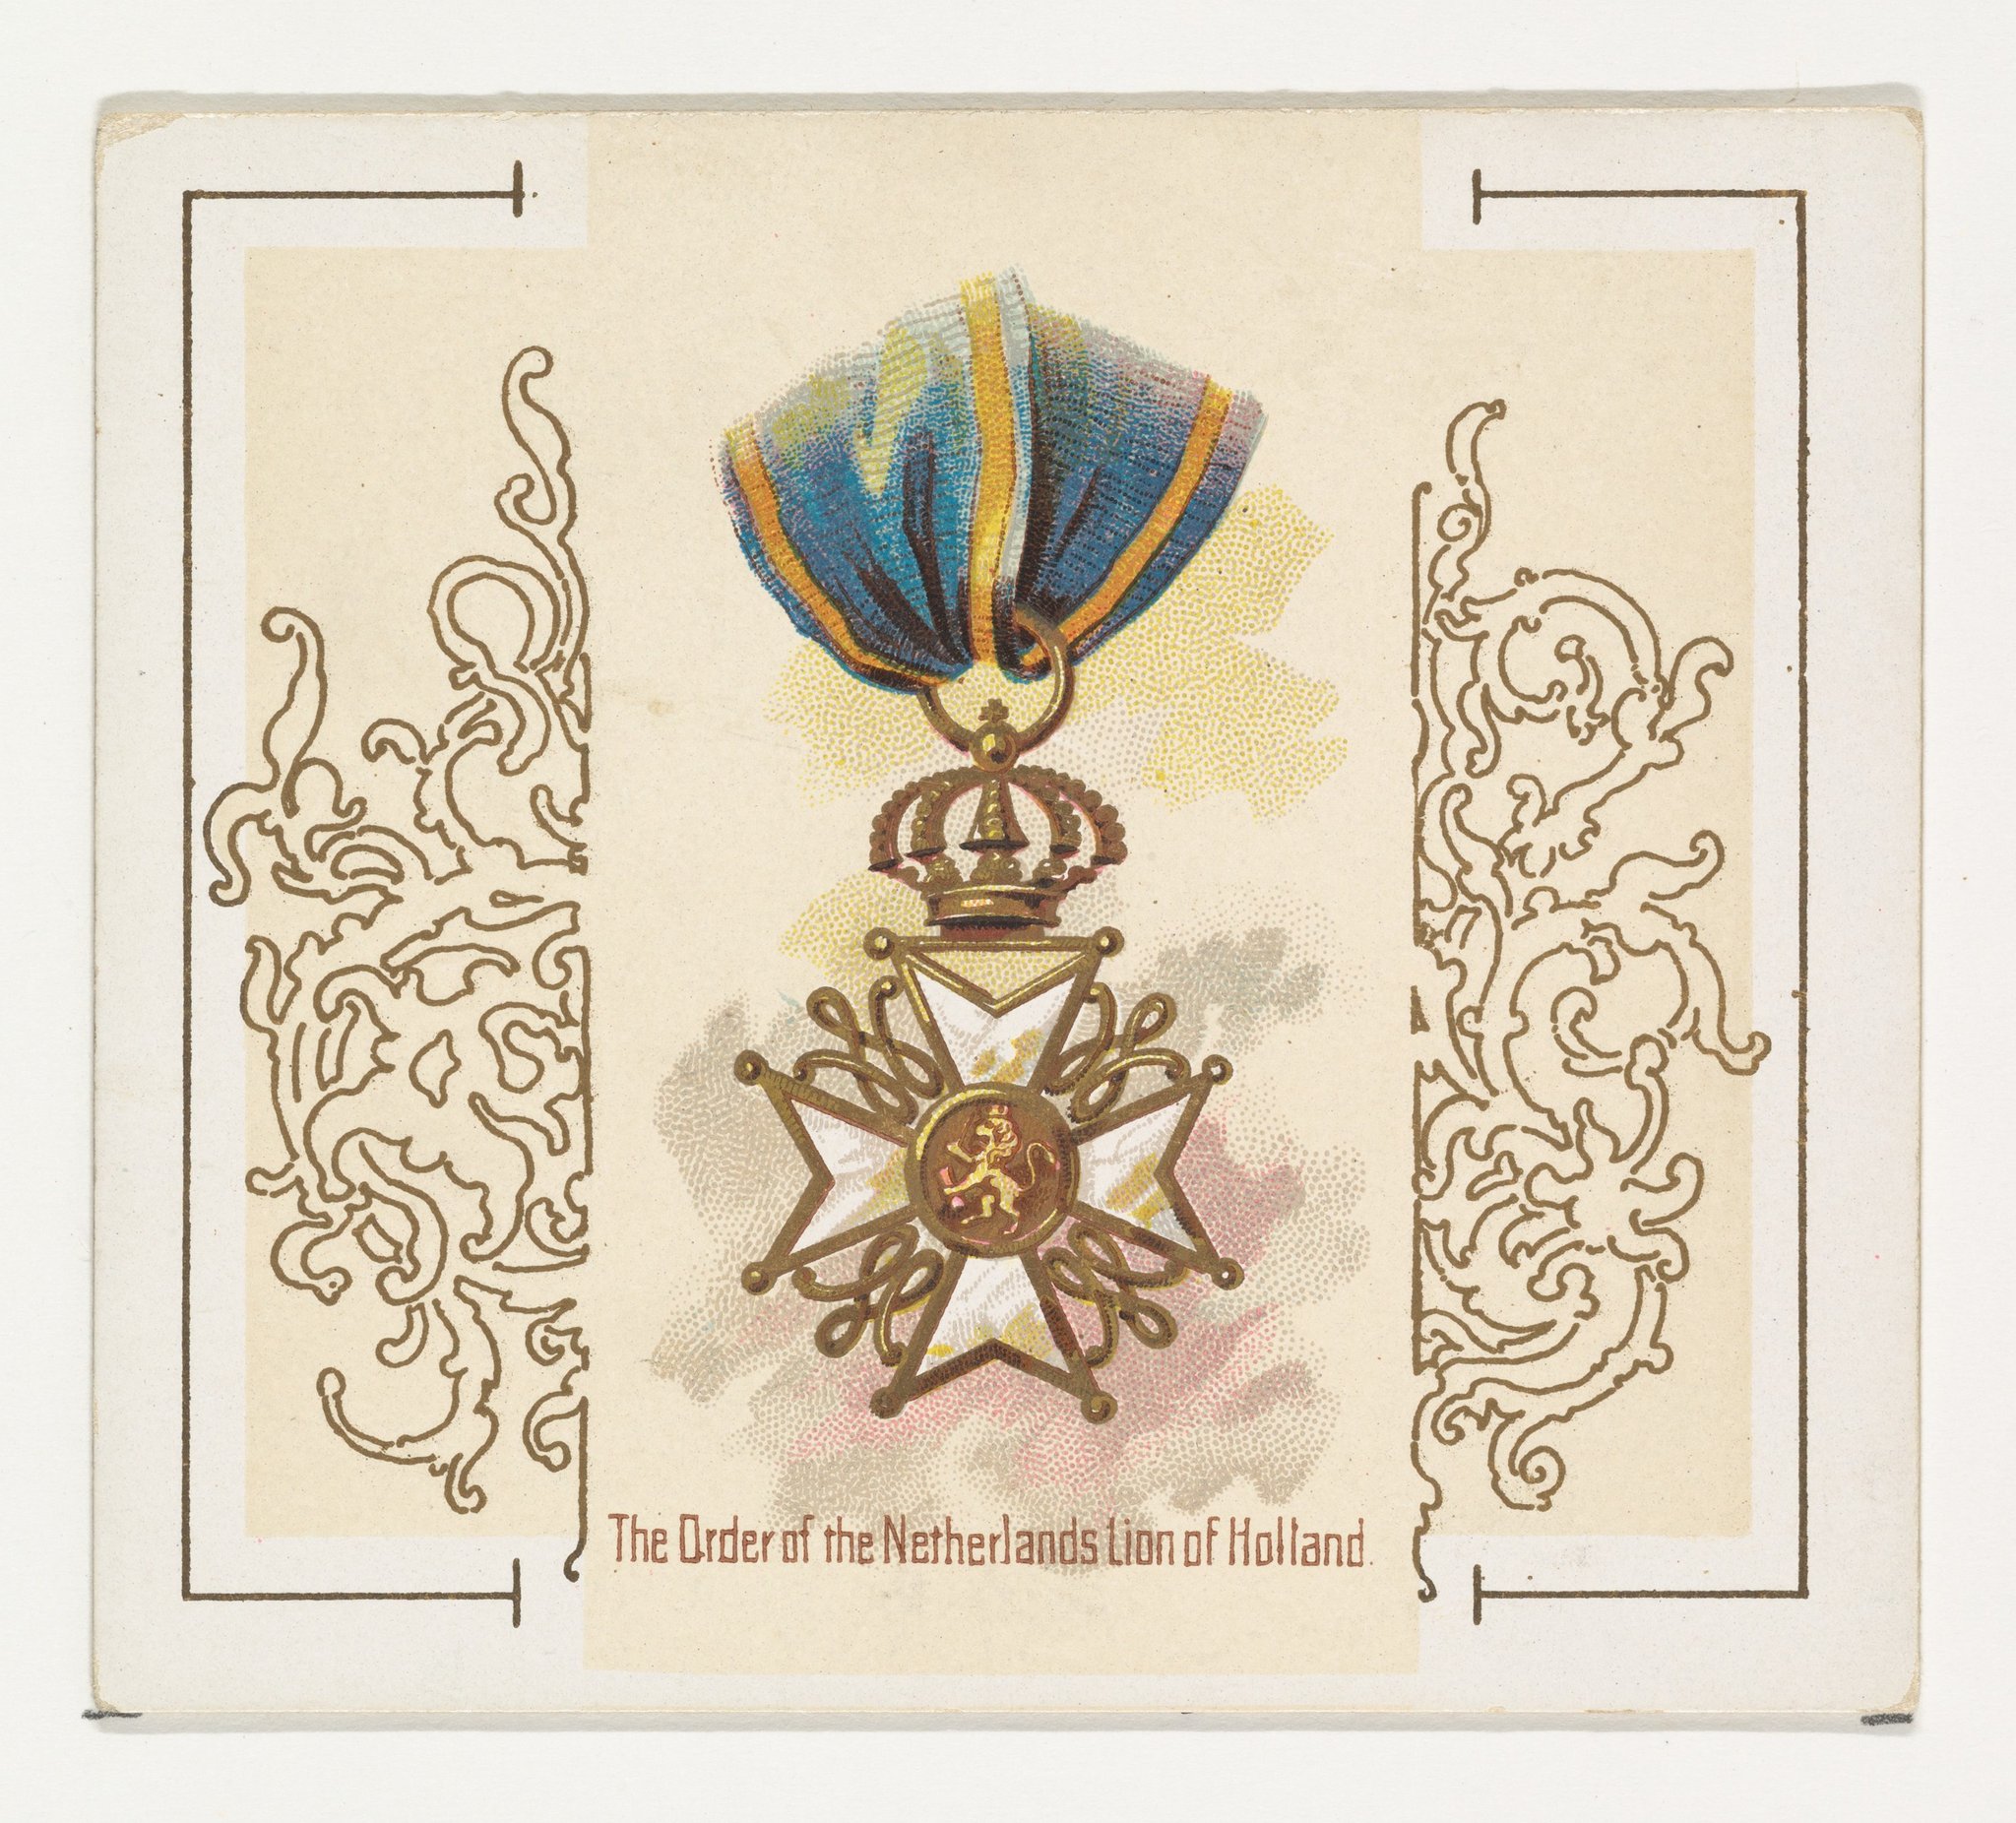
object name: print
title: The Order of the Netherlands Lion of Holland, from the World's Decorations series (N44) for Allen & Ginter Cigarettes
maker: allen & ginter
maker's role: publisher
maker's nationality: american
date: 1890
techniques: color lithograph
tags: medals